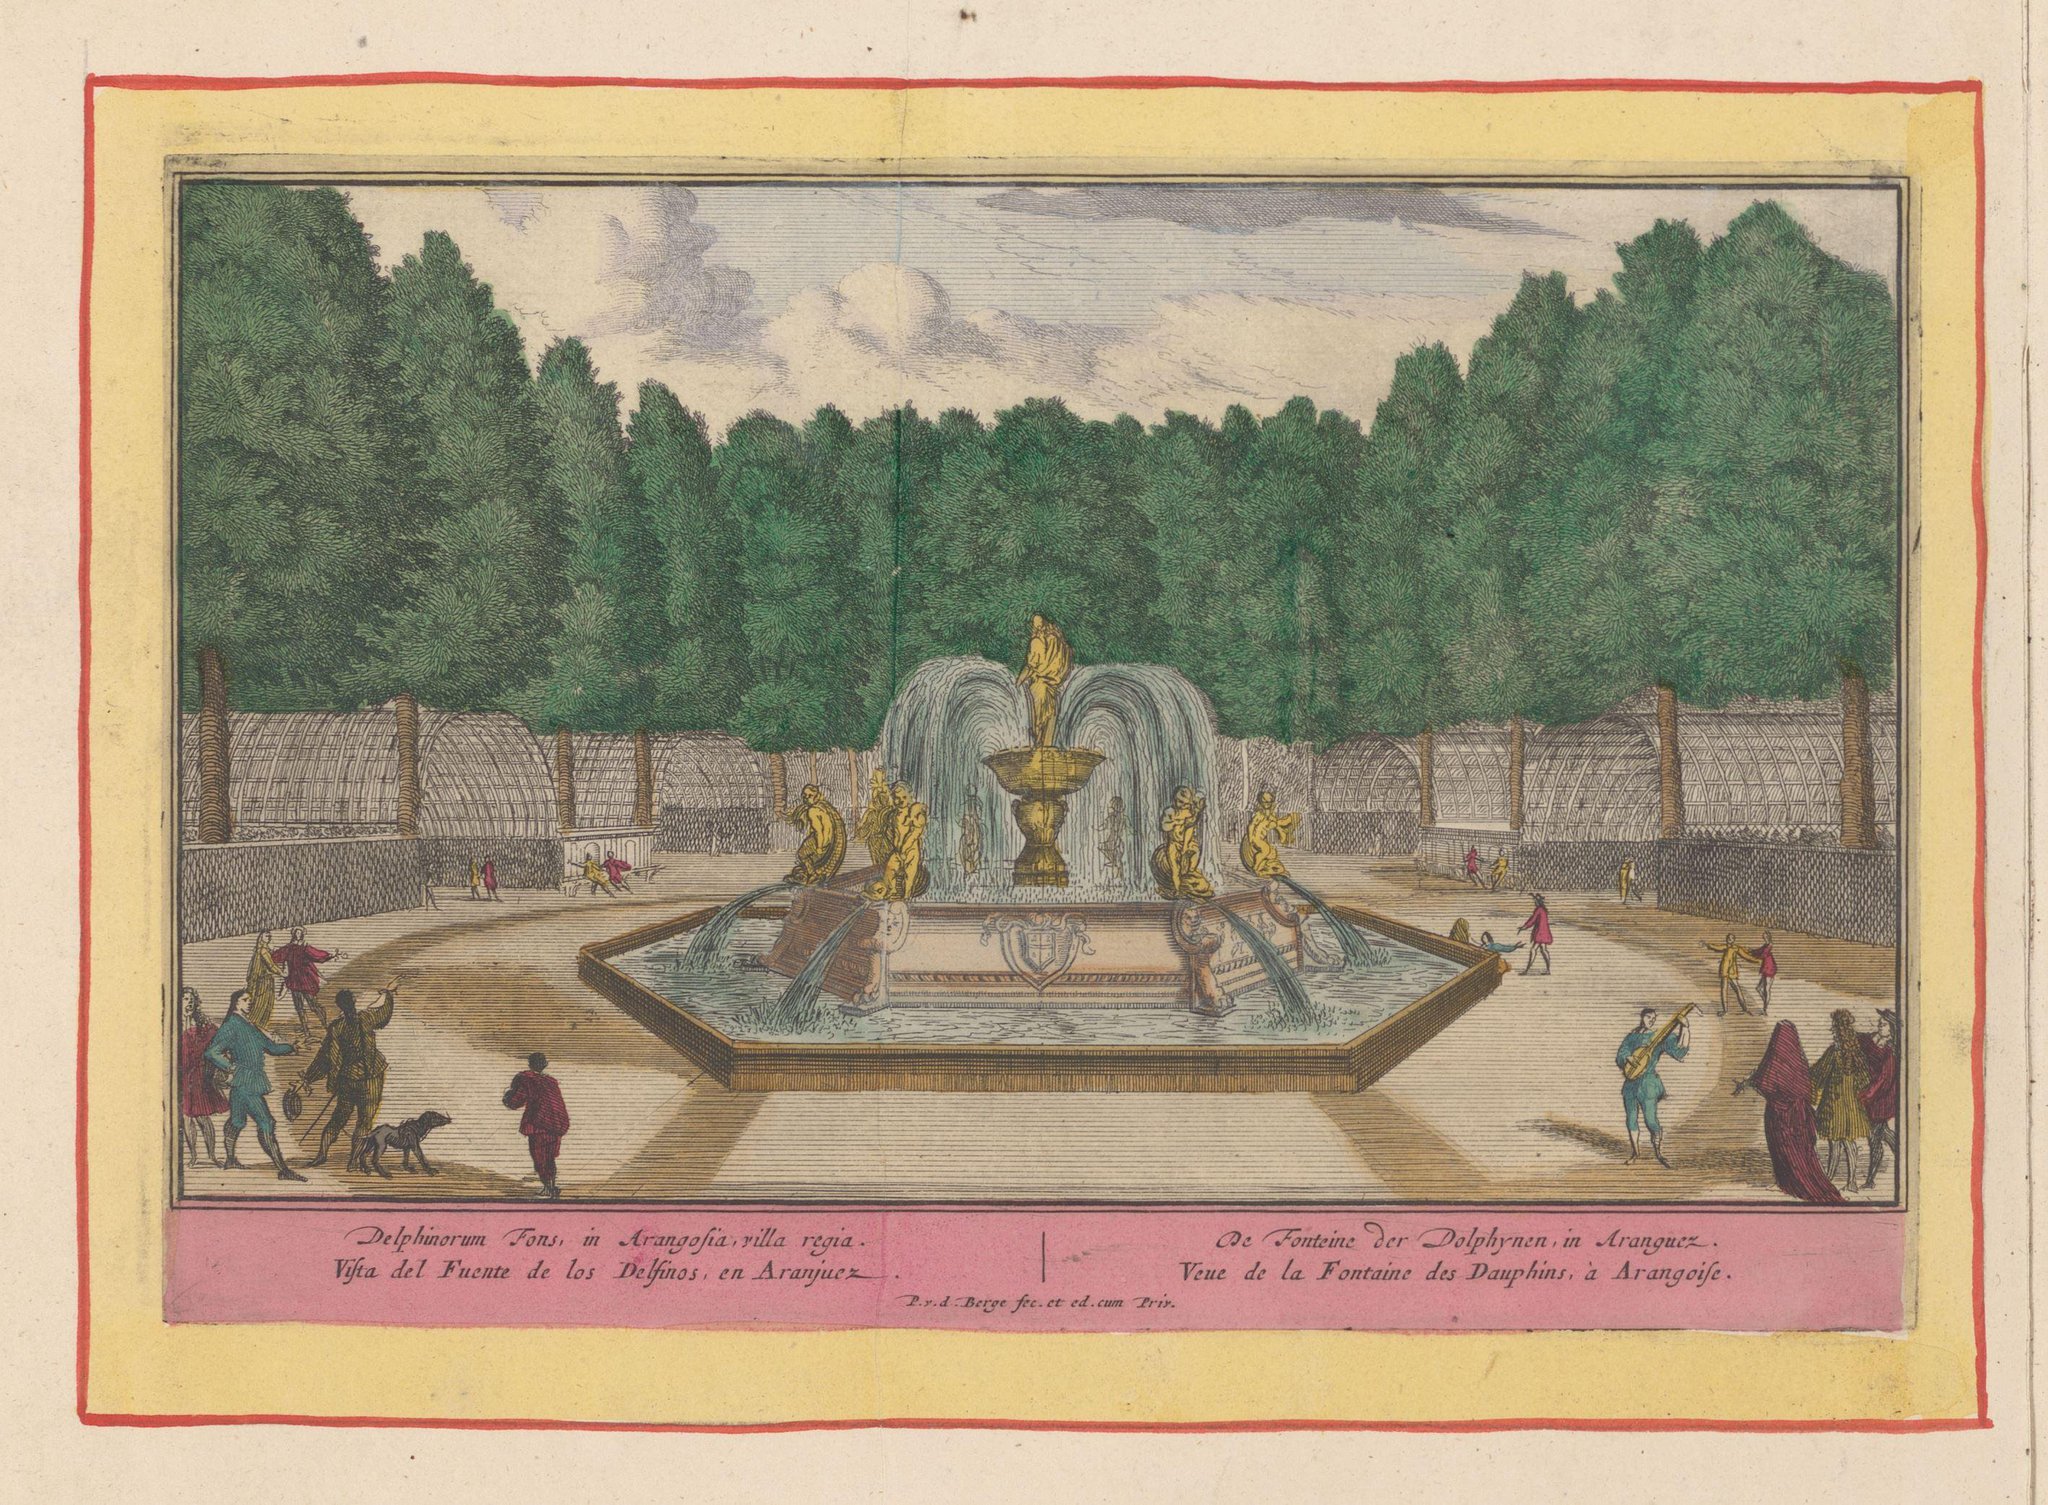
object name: book illustration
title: De Fonteine der Dolphynen, in Aranguez / Delphinorum Fons, in Arangosia, villa regia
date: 1694-1737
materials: paper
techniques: etching, hand coloring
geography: the hague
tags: ornamental fountain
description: Prent uit: Theatrum Hispaniæ, exhibens regni urbes, villas ac viridaria magis illustria. Het aanmerkelykste en voortreffelykste in Spanjen (...). Amsterdam: Pieter van den Berge, ca. 1694-1737.